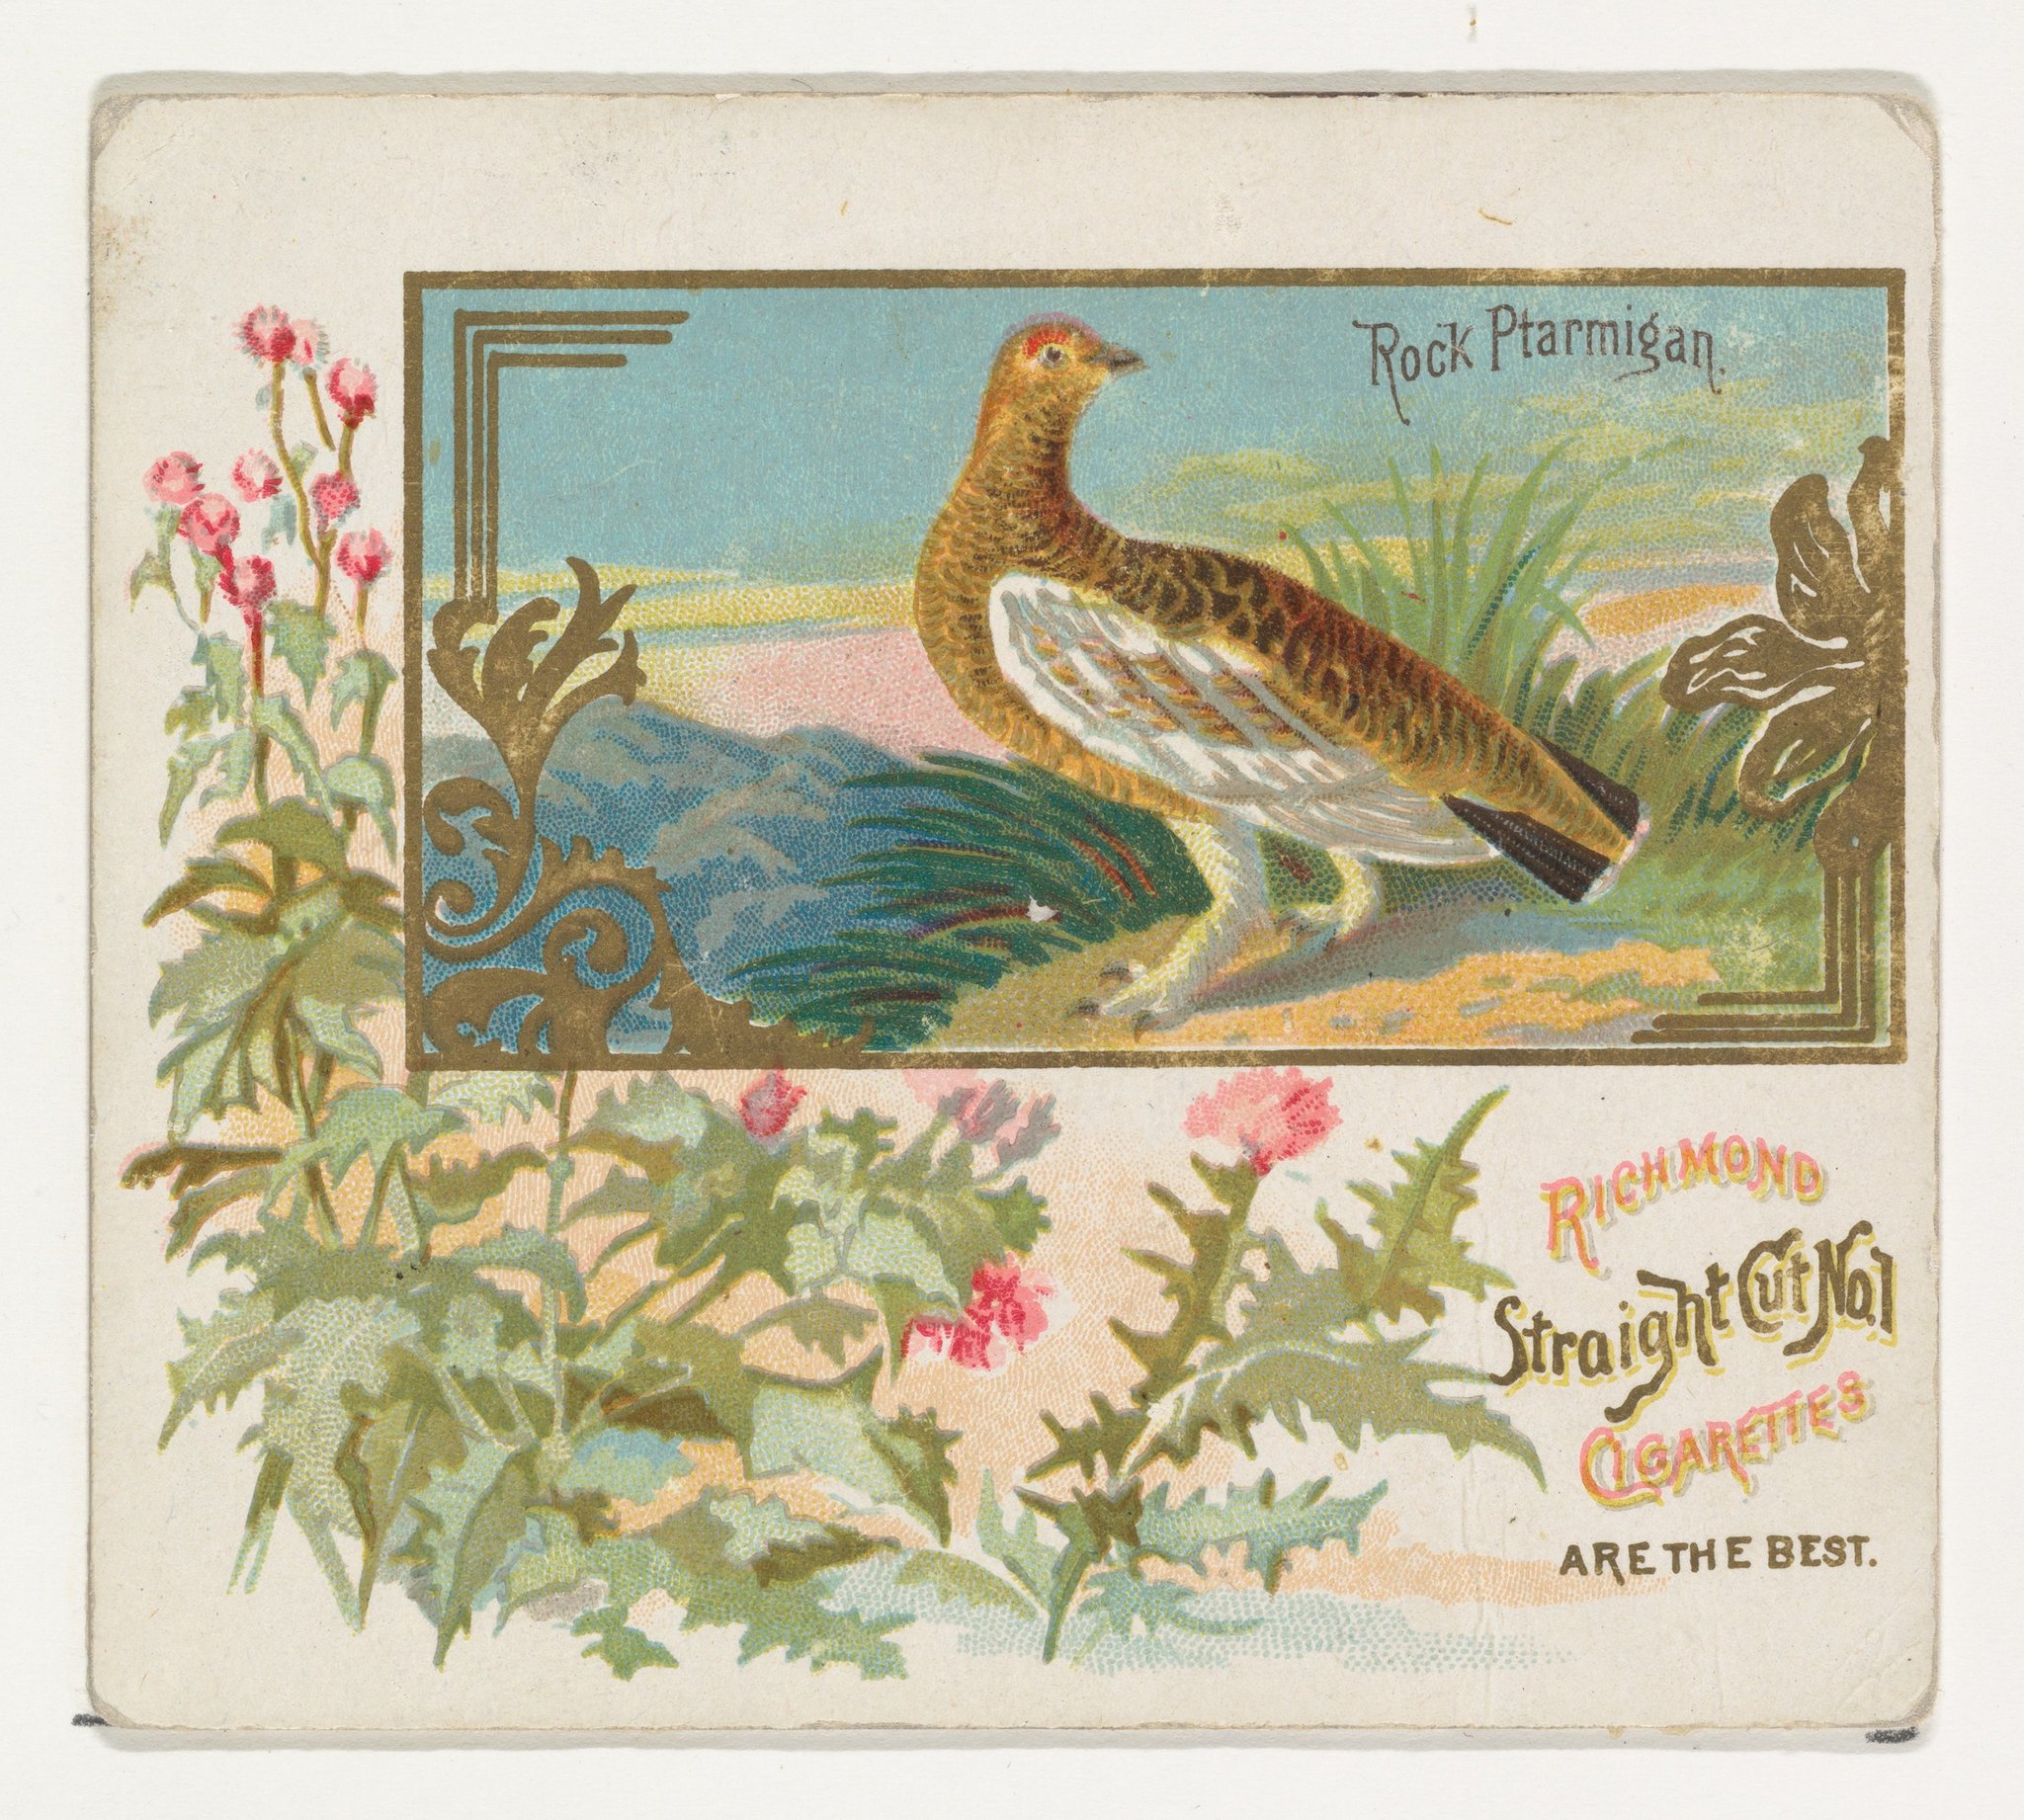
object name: print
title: Rock Ptarmigan, from the Game Birds series (N40) for Allen & Ginter Cigarettes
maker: allen & ginter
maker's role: publisher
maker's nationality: american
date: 1888-1890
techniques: color lithograph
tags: birds